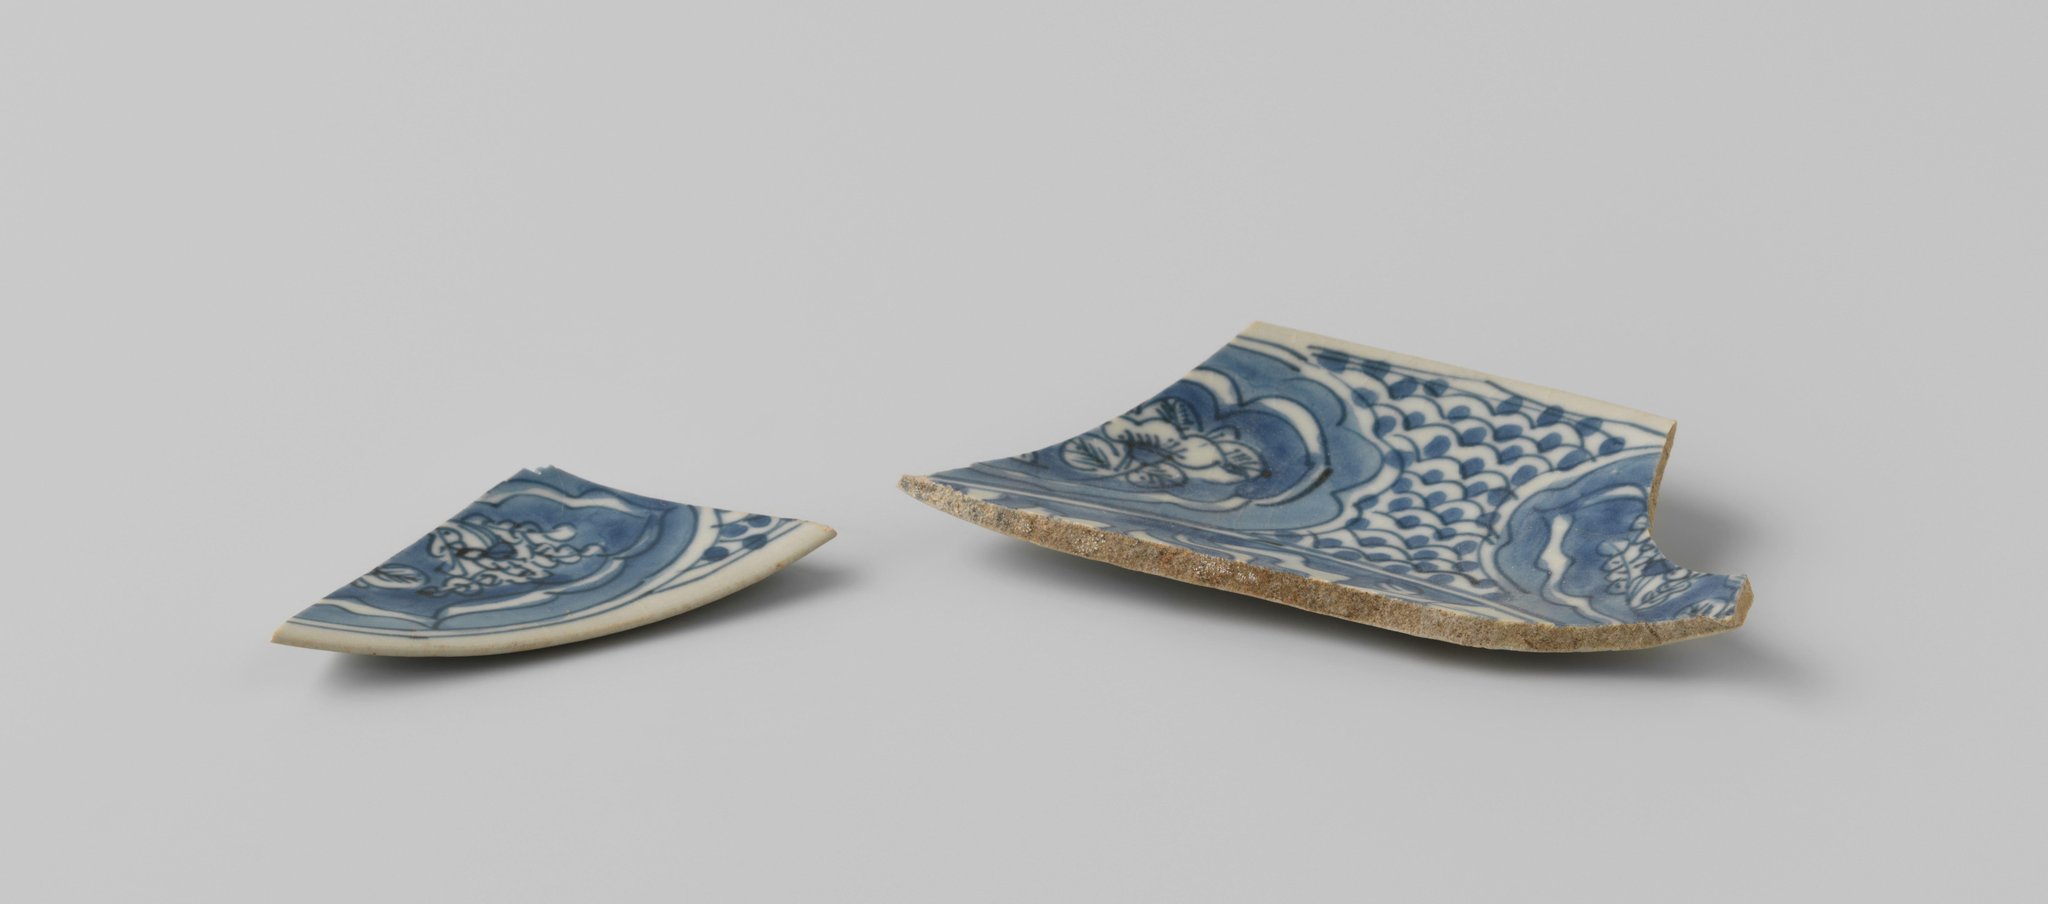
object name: plate dish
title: Scherven van een bord uit V.O.C.-schip de 'Witte Leeuw'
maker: Anonymous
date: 1613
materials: porcelain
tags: verenigde oostindische compagnie, sint-helena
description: Scherven van een bord uit V.O.C.-schip de 'Witte Leeuw'.